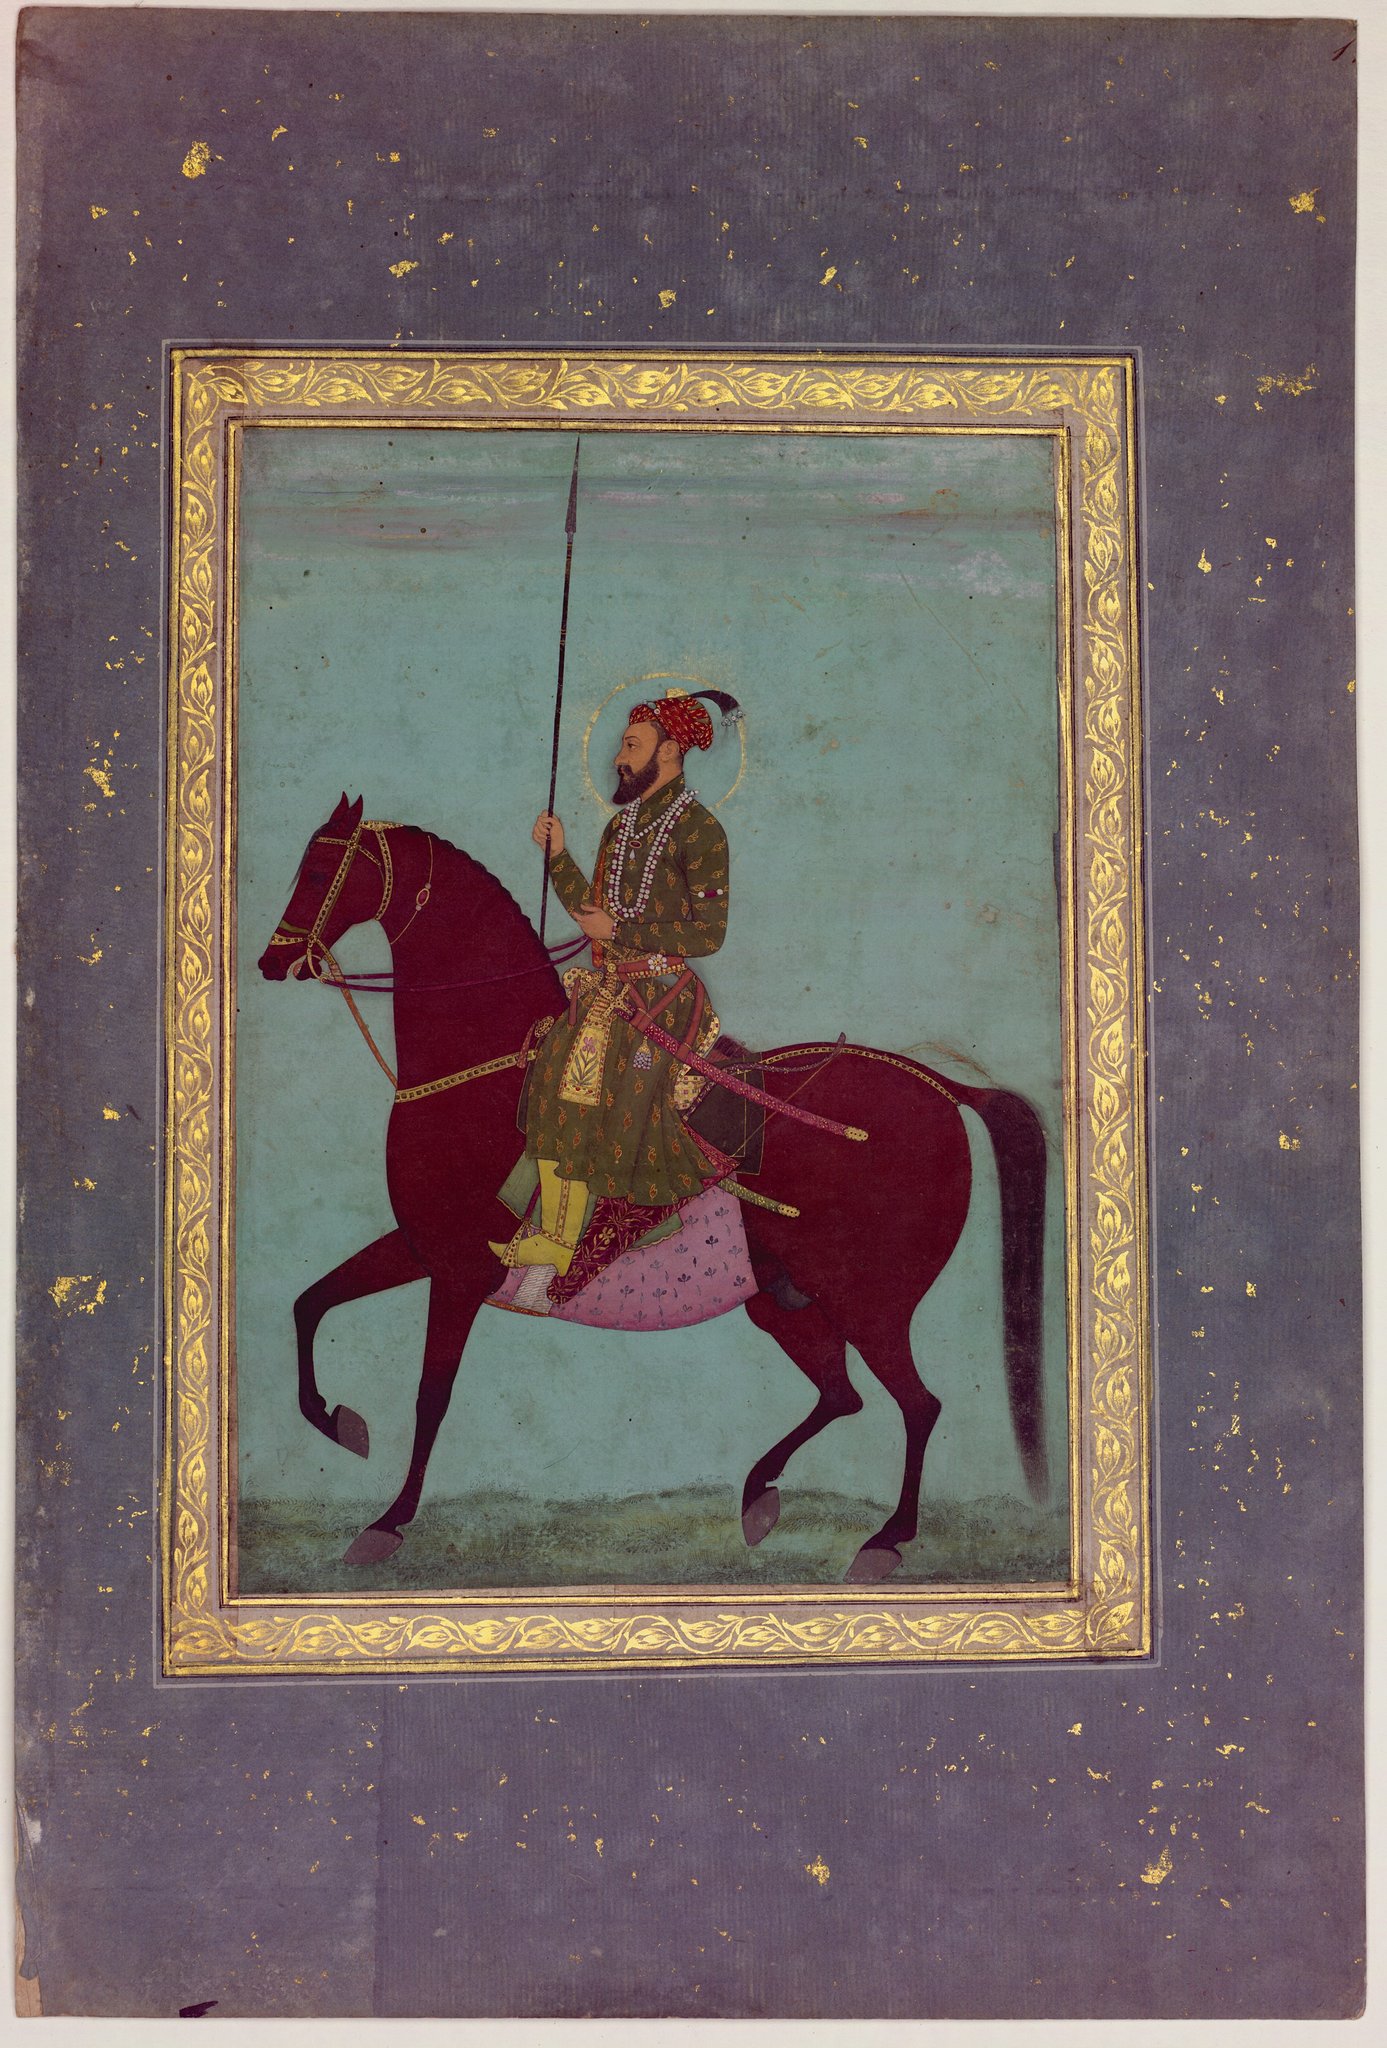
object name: illustrated album leaf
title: Equestrian Portrait of Aurangzeb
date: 1601-1700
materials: paper, watercolor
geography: india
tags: men,portraits,horses